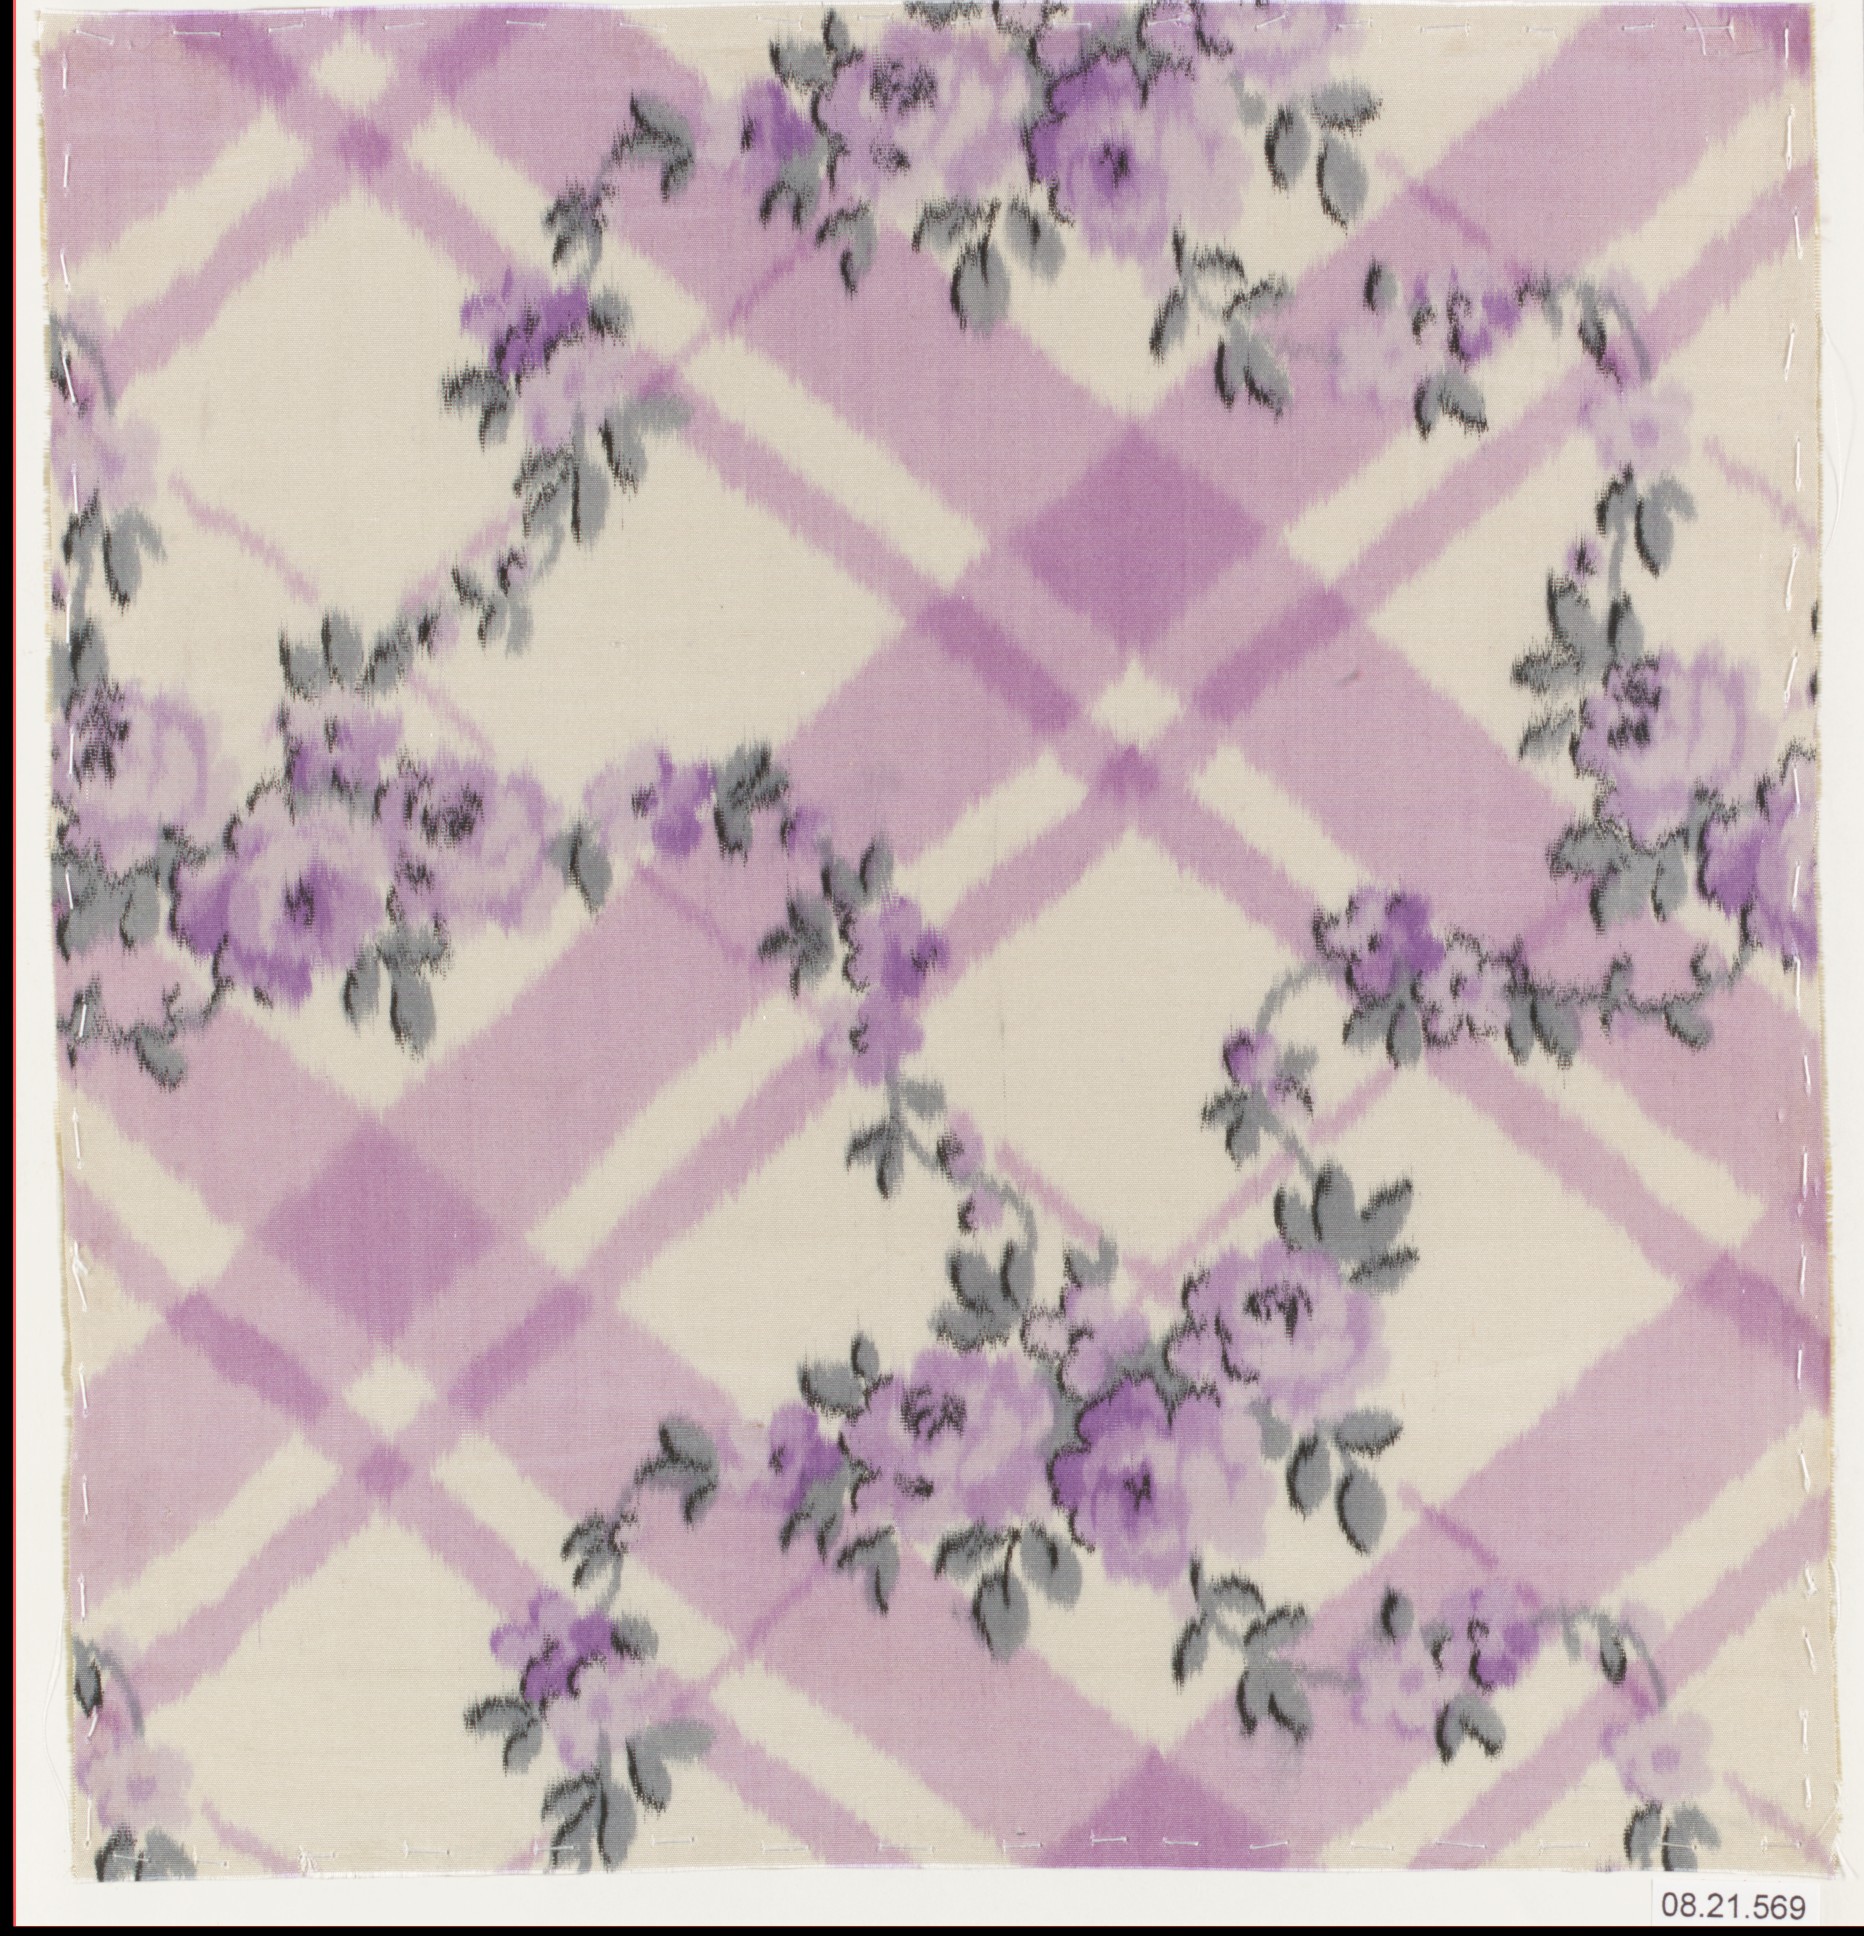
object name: textile sample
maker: Anonymous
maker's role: designer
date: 1900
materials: silk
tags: flowers